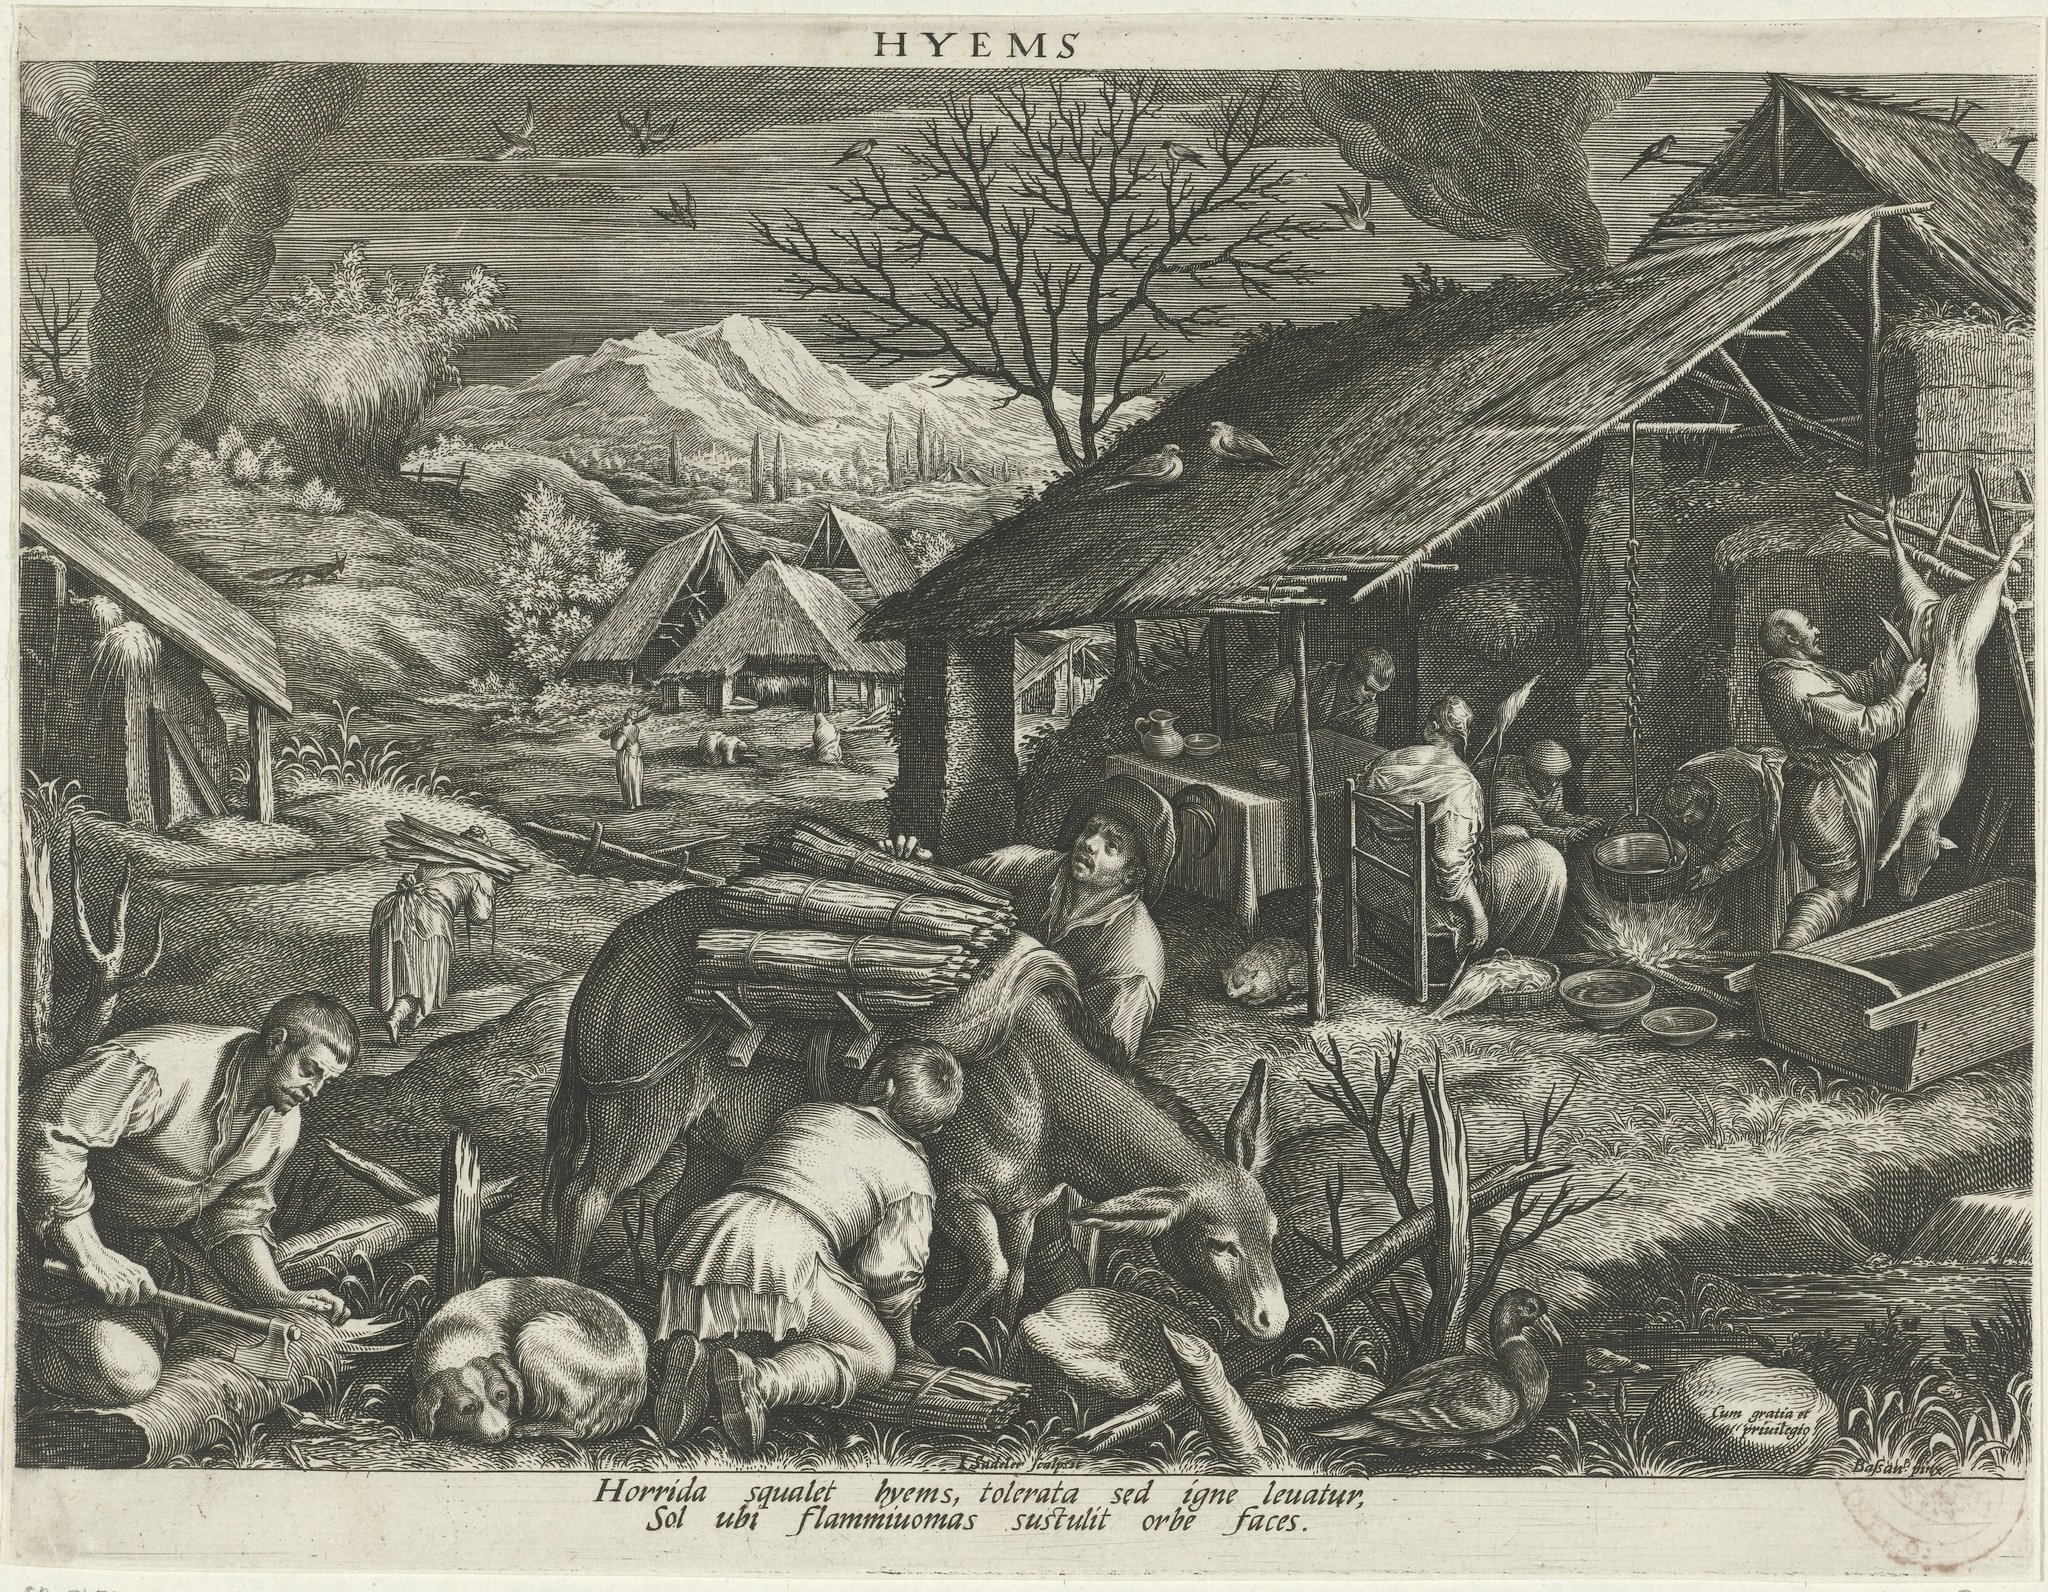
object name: print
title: Winter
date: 1587-1595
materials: paper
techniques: engraving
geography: germany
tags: woodgathering, woodgatherer, woodcutting, woodcutter ~ forestry, winter ~ human activities (the four seasons of the year), slaughtered ox or pig, butcher, slaughterman, transport of timber, timber-trailer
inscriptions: collector's mark: Lugt 240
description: Een winters landschap met winterse activiteiten. Op de voorgrond wordt hout gekapt en verzameld. Een ezel vervoert de takkenbossen op de rug. Rechtsachter een boerderij waarvoor een varken wordt geslacht. Onder een afdak zit een vrouw te spinnen. De prent heeft een Latijns onderschrift en maakt deel uit van een vierdelige serie met als onderwerp de vier seizoenen.